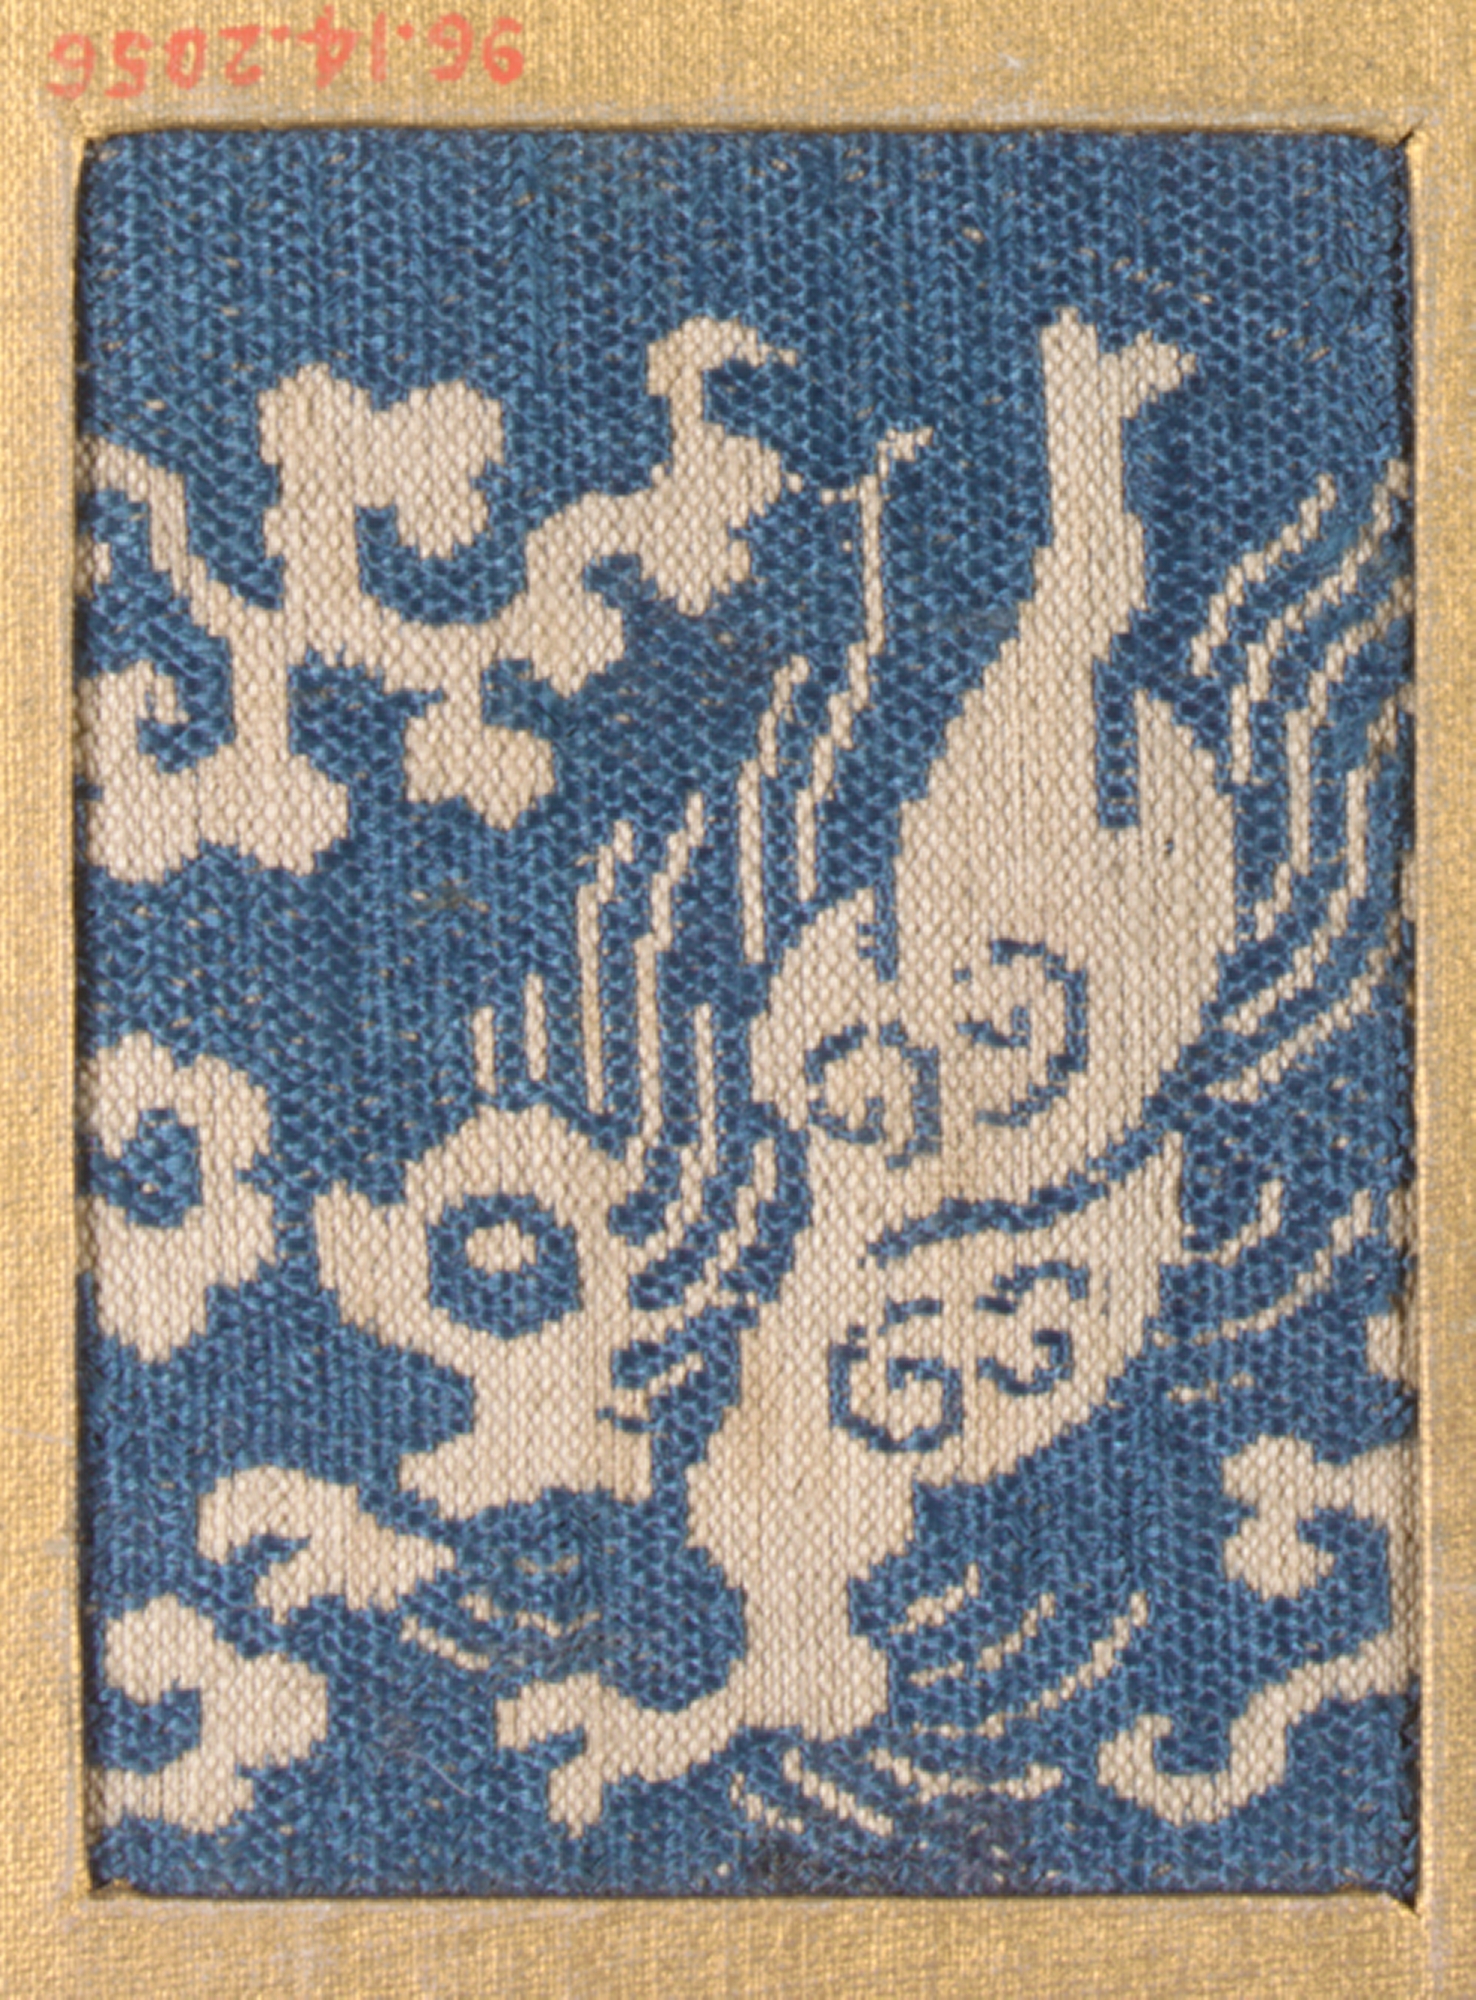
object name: piece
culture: japanese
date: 1701-1900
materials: silk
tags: animals